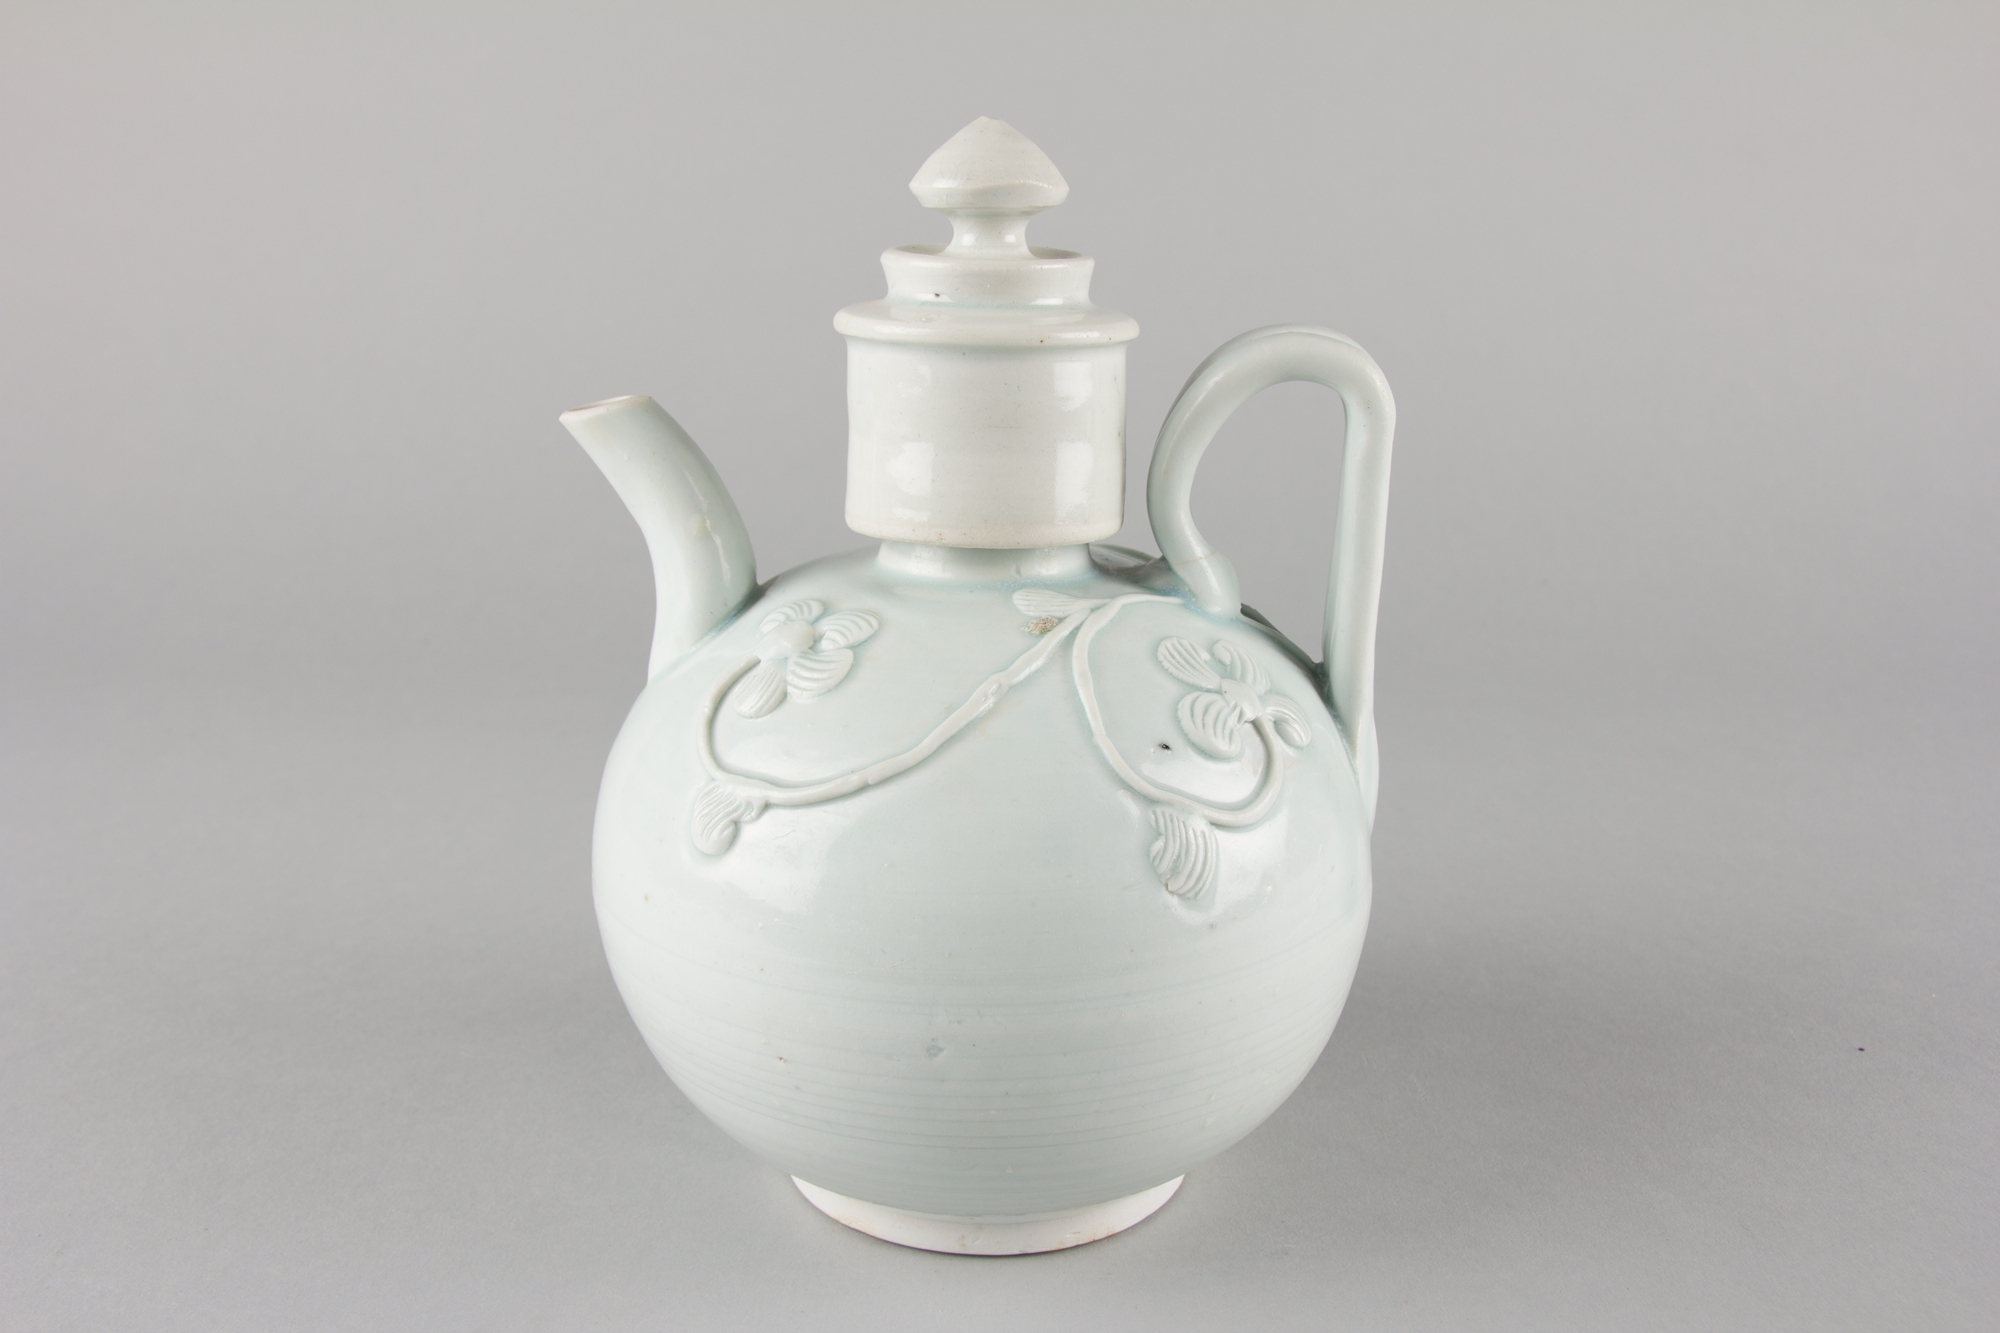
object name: ewer with cover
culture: chinese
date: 1101-1200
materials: porcelain